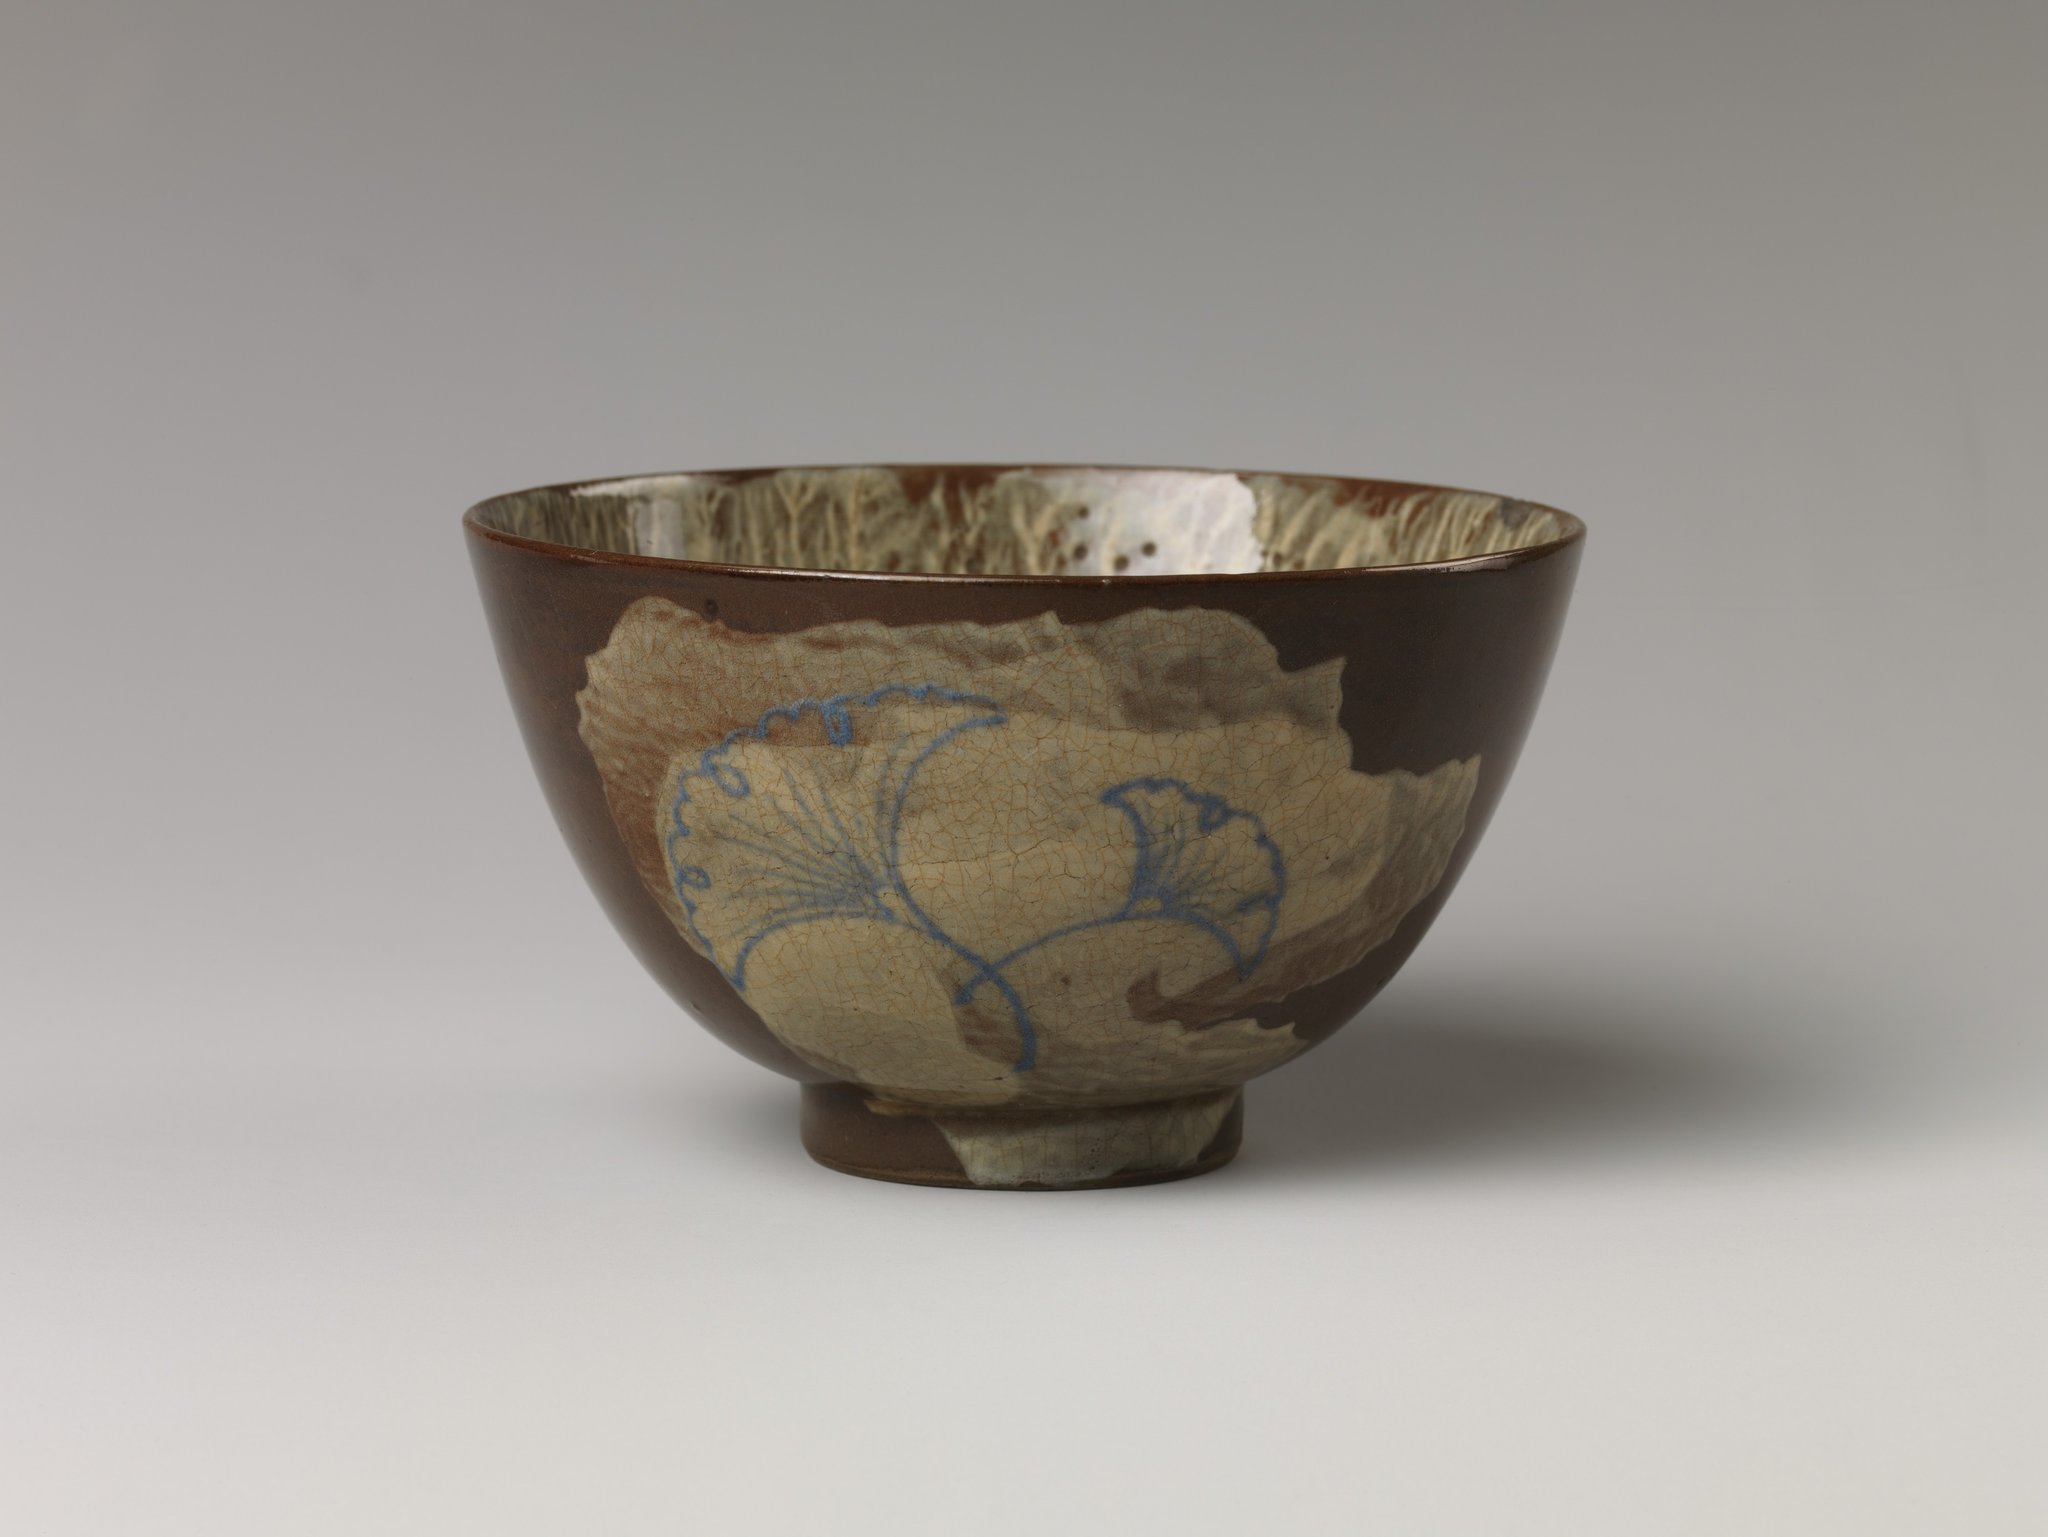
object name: teabowl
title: Tea Bowl with Decoration of Gingko Leaves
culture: japanese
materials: cobalt, stoneware